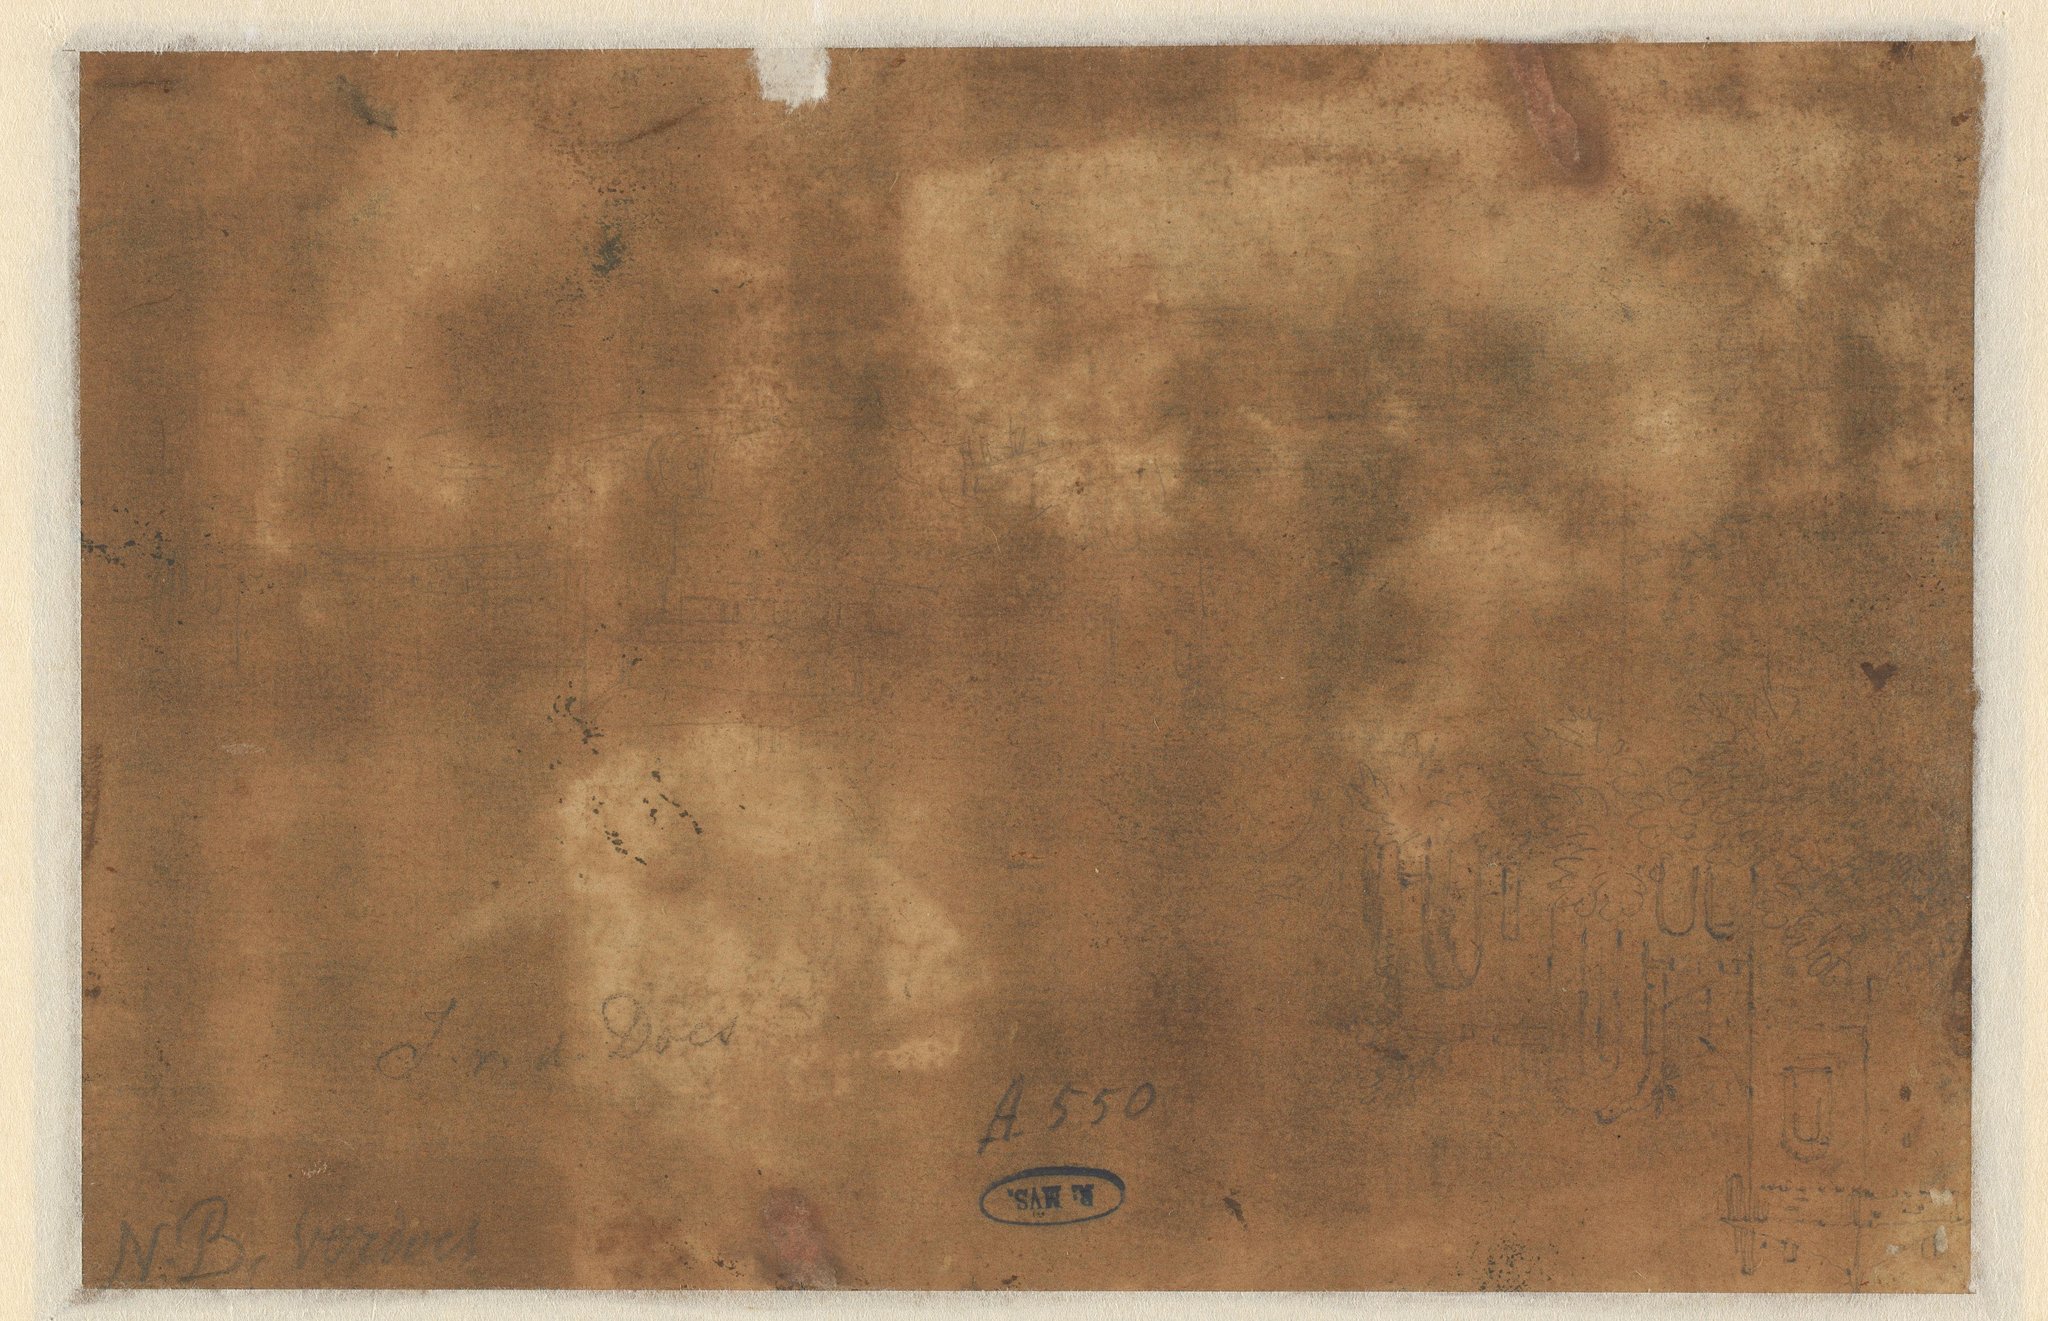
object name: drawing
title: Sketch of an Italian Tower next to a City Wall behind Trees with a Ruined Structure and Park / recto: Five Studies of the Head of a Sheep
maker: jacob van der does (i)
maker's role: draughtsman, painter, print maker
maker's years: 1623-1673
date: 1633-1673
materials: paper, pencil